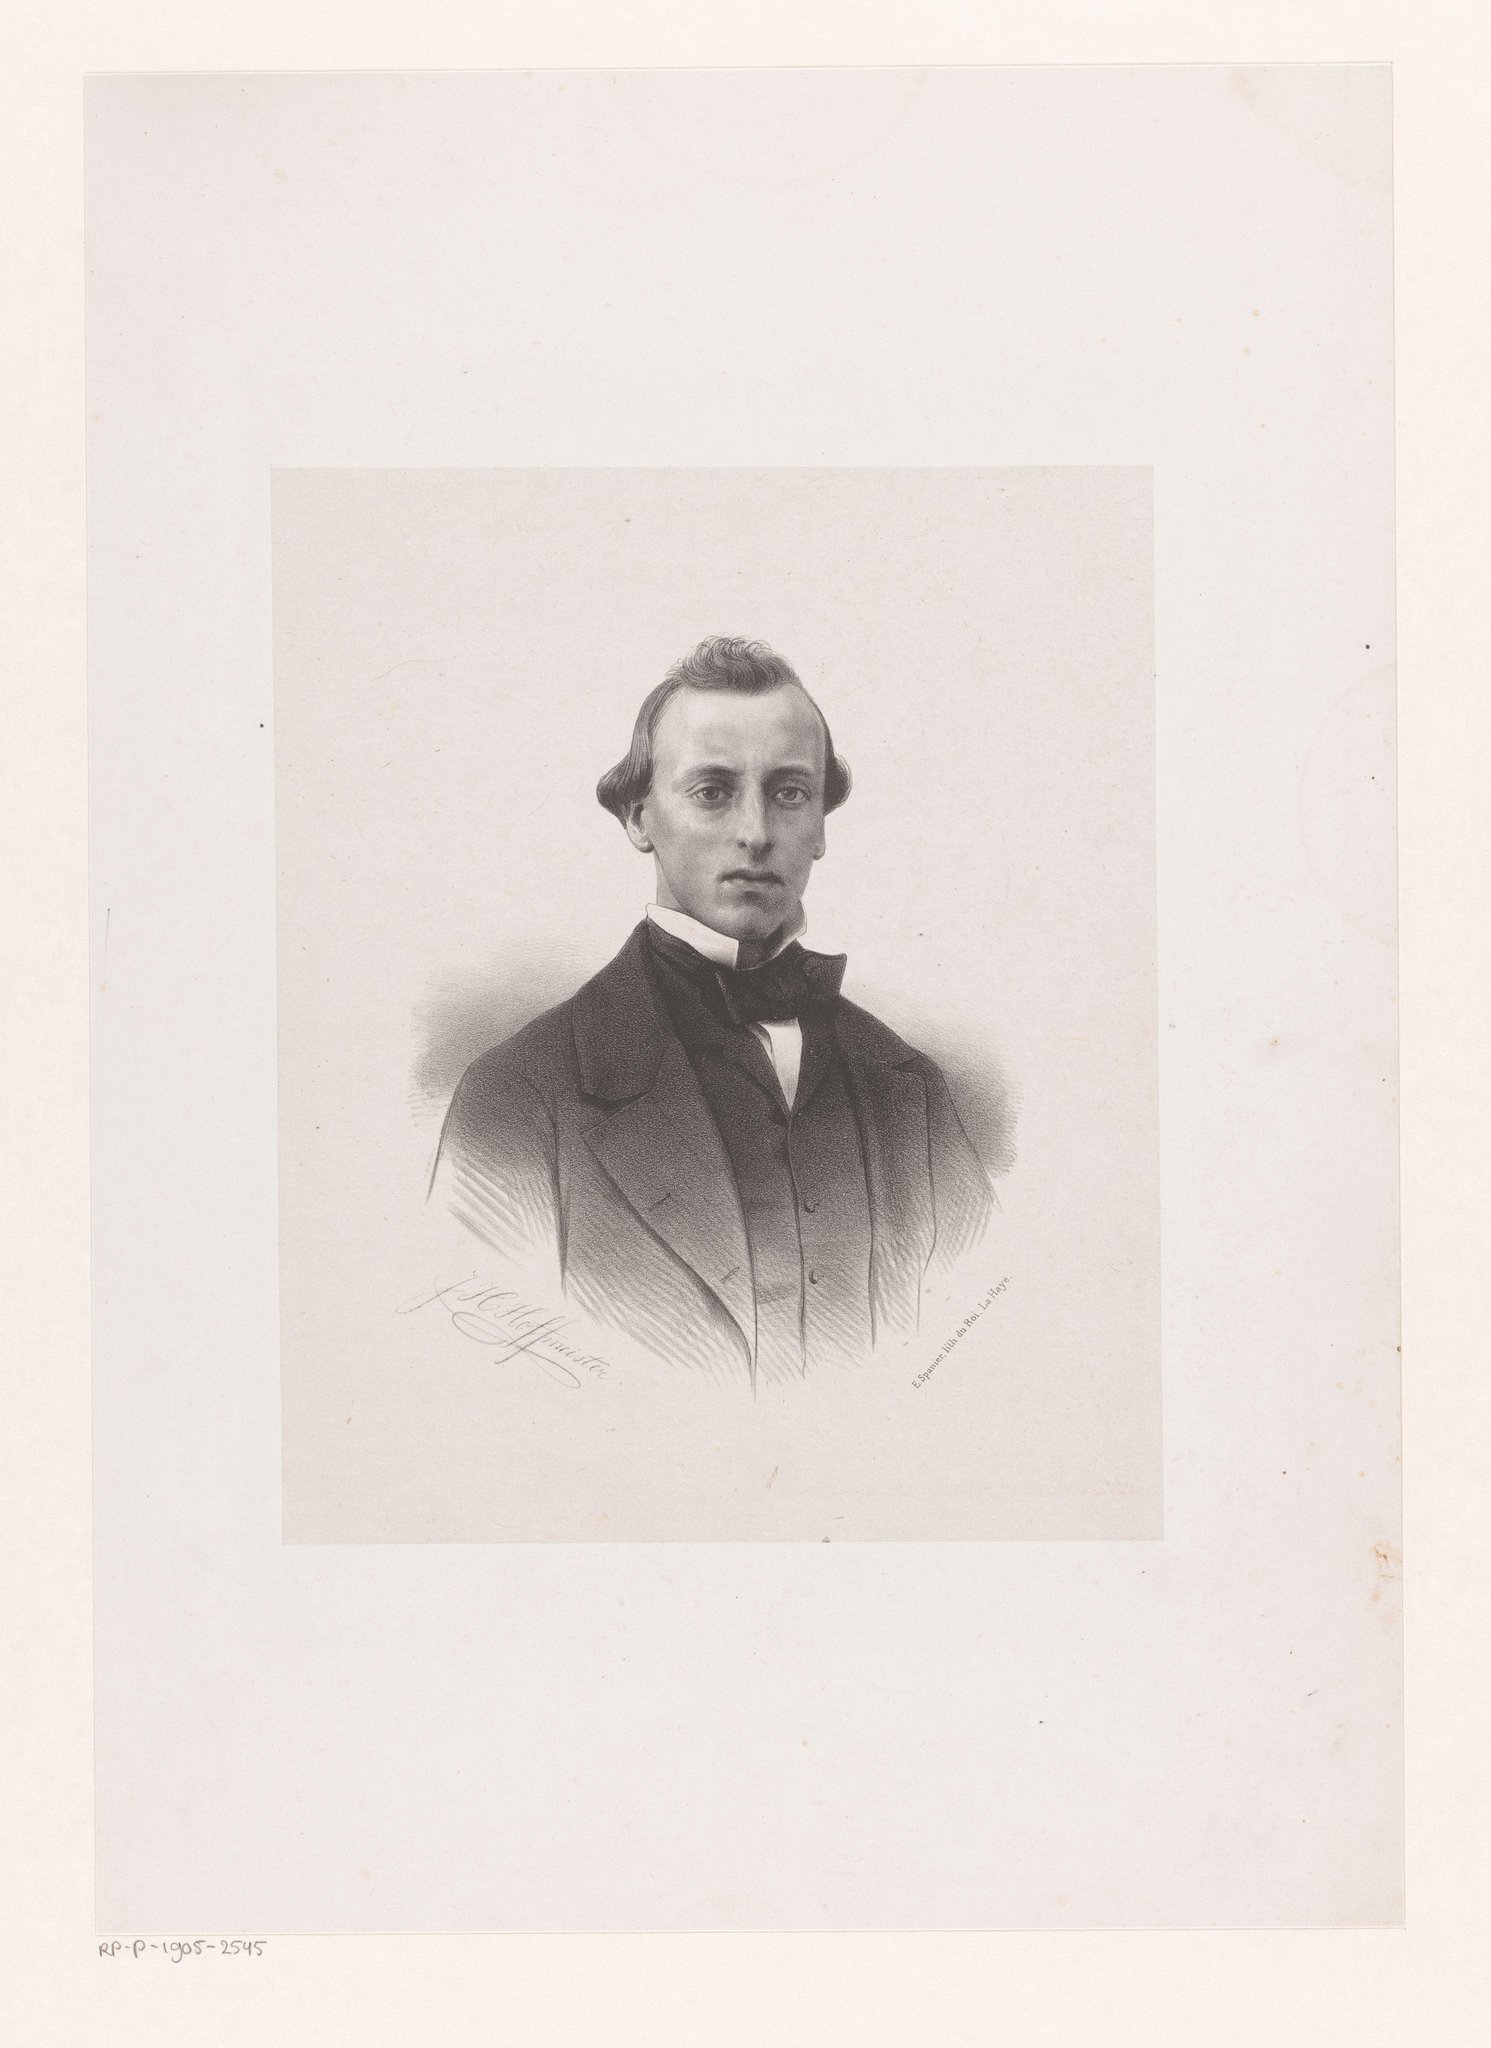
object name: print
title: Portret van een onbekende man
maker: johan hendrik hoffmeister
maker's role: print maker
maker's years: 1823-1904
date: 1851-1883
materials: paper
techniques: lithograph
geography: the hague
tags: historical persons (+ (full) bust portrait)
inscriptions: collector's mark: Lugt 2228